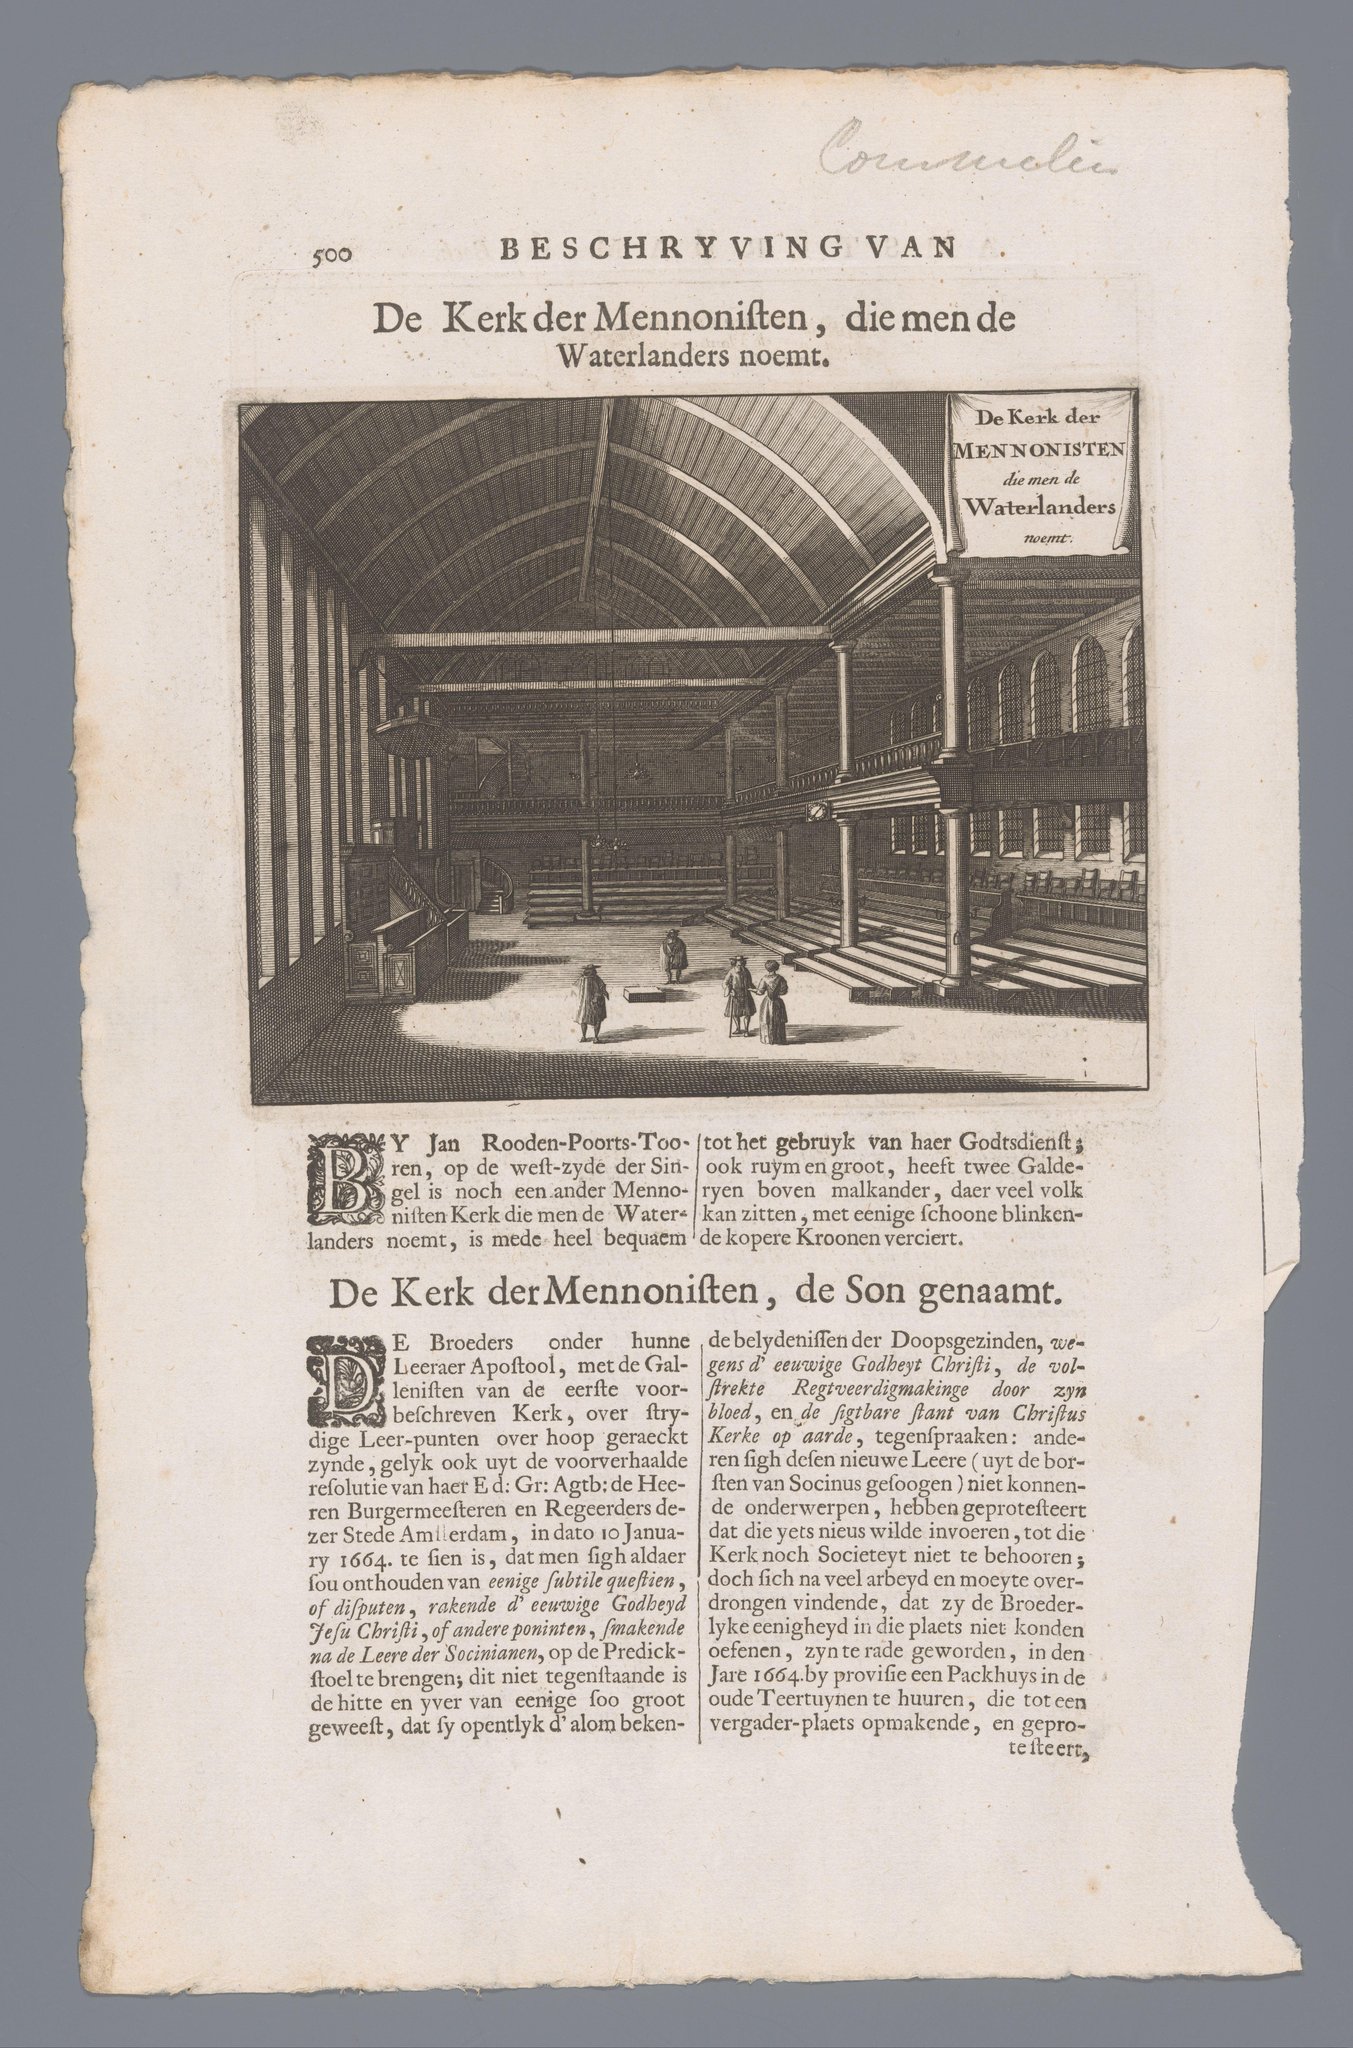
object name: print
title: De Kerk der Mennonisten die men de Waterlanders noemt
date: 1726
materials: paper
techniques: etching, letterpress printing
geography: amsterdam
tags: protestant churches and denominations (mennonites), interior of church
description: Prent uit: Commelin, Caspar. Beschryvinge van Amsterdam, zynde een naukeurige verhandelinge van desselfs eerste oorspronk uyt (…). Amsterdam: Andries van Damme et al., 1726, p. 500. Prent in eerdere staat gebruikt in: Commelin, Caspar. Beschryvinge van Amsterdam, desselfs eerste oorspronk uyt den Huyse (…). Amsterdam: Abraham Wolfgang et al., 1693. En in: Commelin, Caspar. Beschryvinge van Amsterdam, zynde een naukeurige verhandelinge van desselfs eerste oorspronk uyt (…). Amsterdam: weduwe Aart Dircksz Oossaan, 1694.